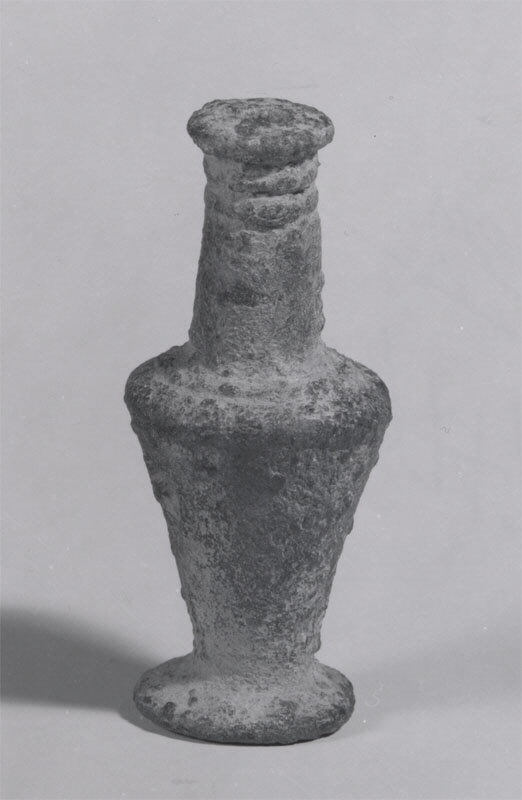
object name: cosmetic container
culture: bactria-margiana archaeological complex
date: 2333-1668 BCE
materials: copper alloy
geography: bactria-margiana